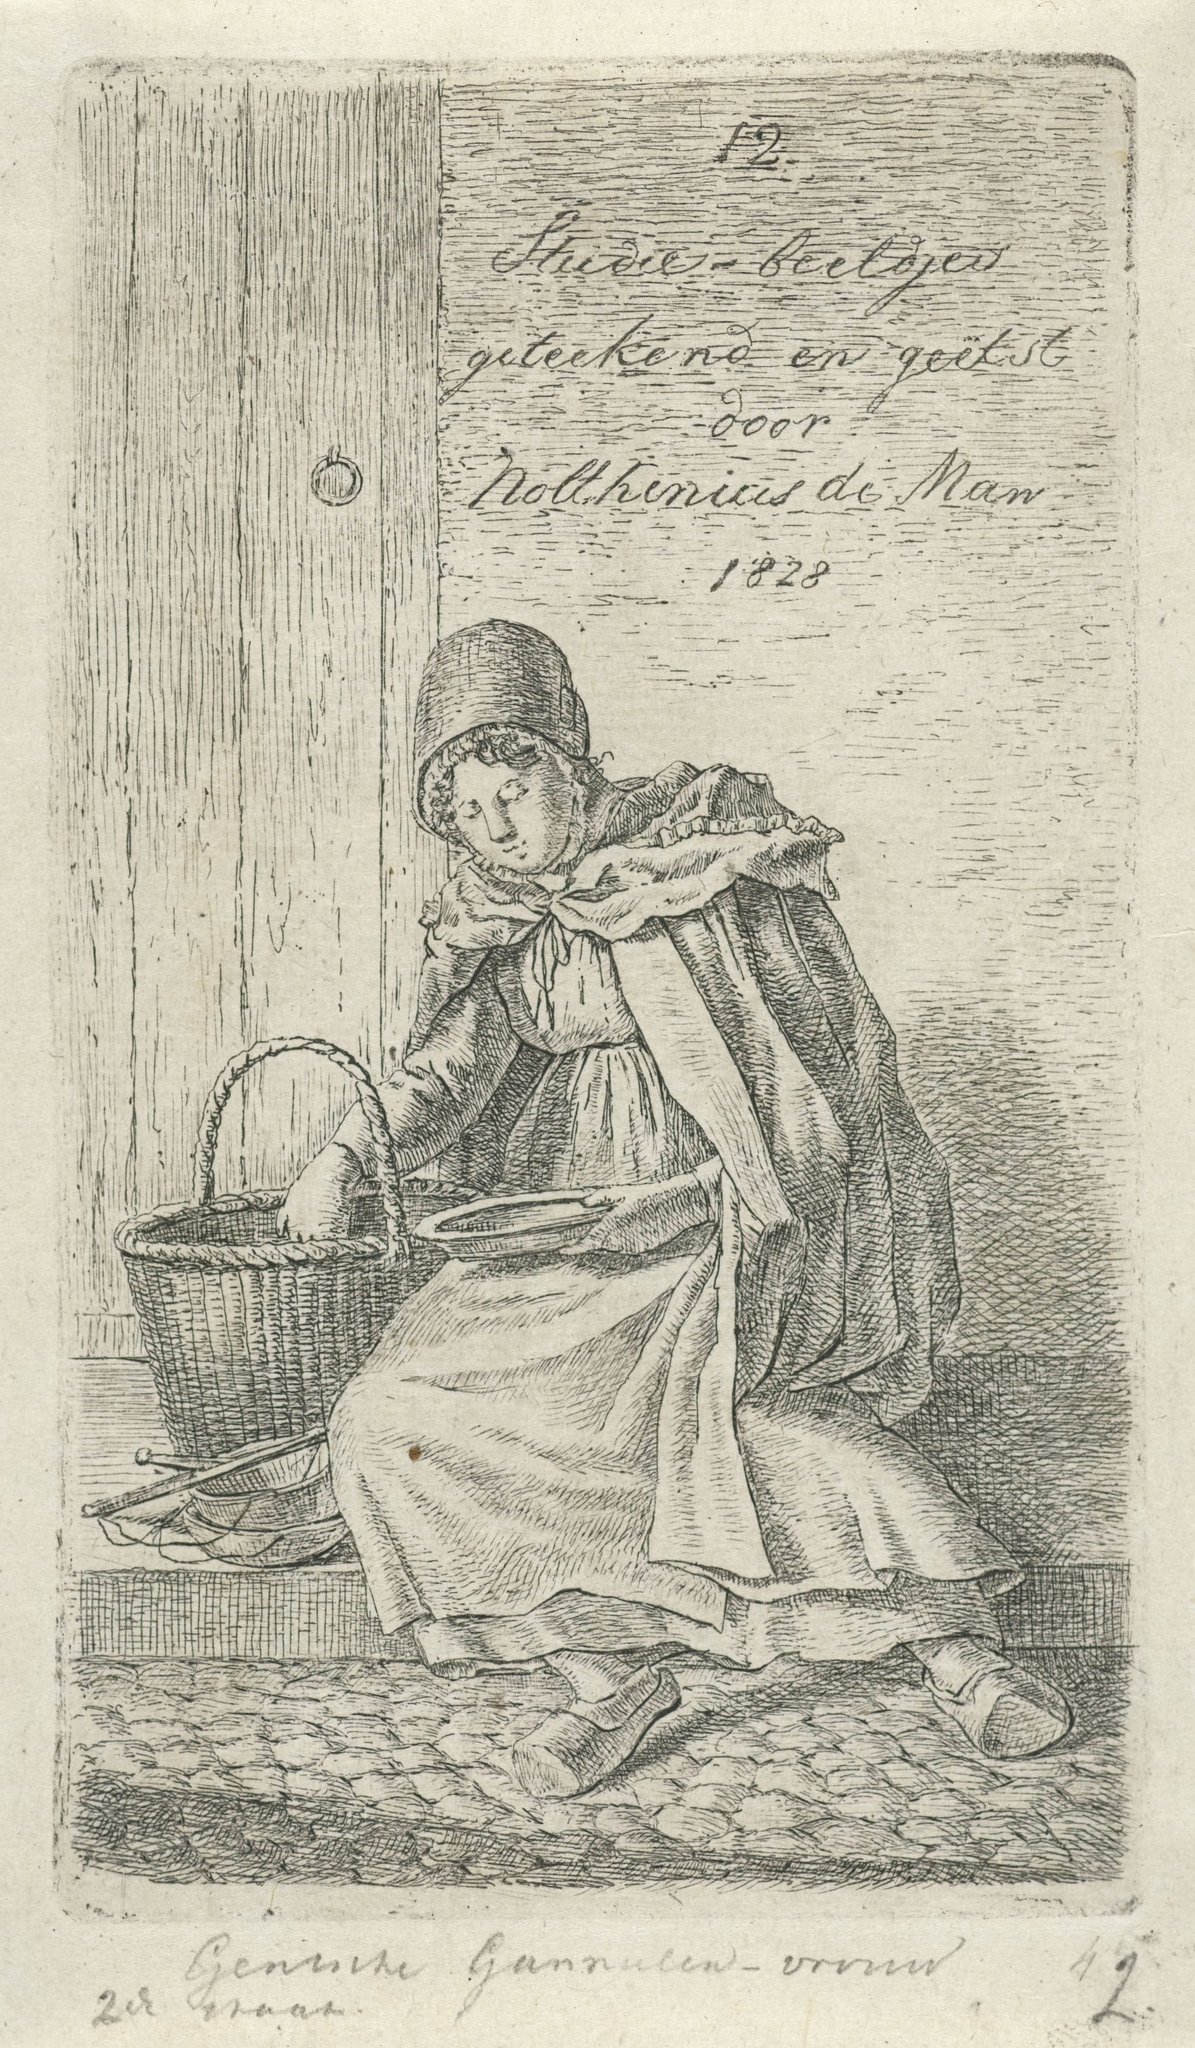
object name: print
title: Zittende vrouw met mand en bord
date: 1828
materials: paper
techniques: etching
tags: sitting figure - aa - female human figure, container made of plant material other than wood: basket, dish, plate, saucer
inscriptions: collector's mark: Lugt 2227, inscription: ‘2de staat Gentsche Garnalen-vrouw’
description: Een vrouw met een bord op haar schoot, zittend op een stoep voor een deur. Prent uit een serie van twaalf prenten met studies van menselijke figuren.